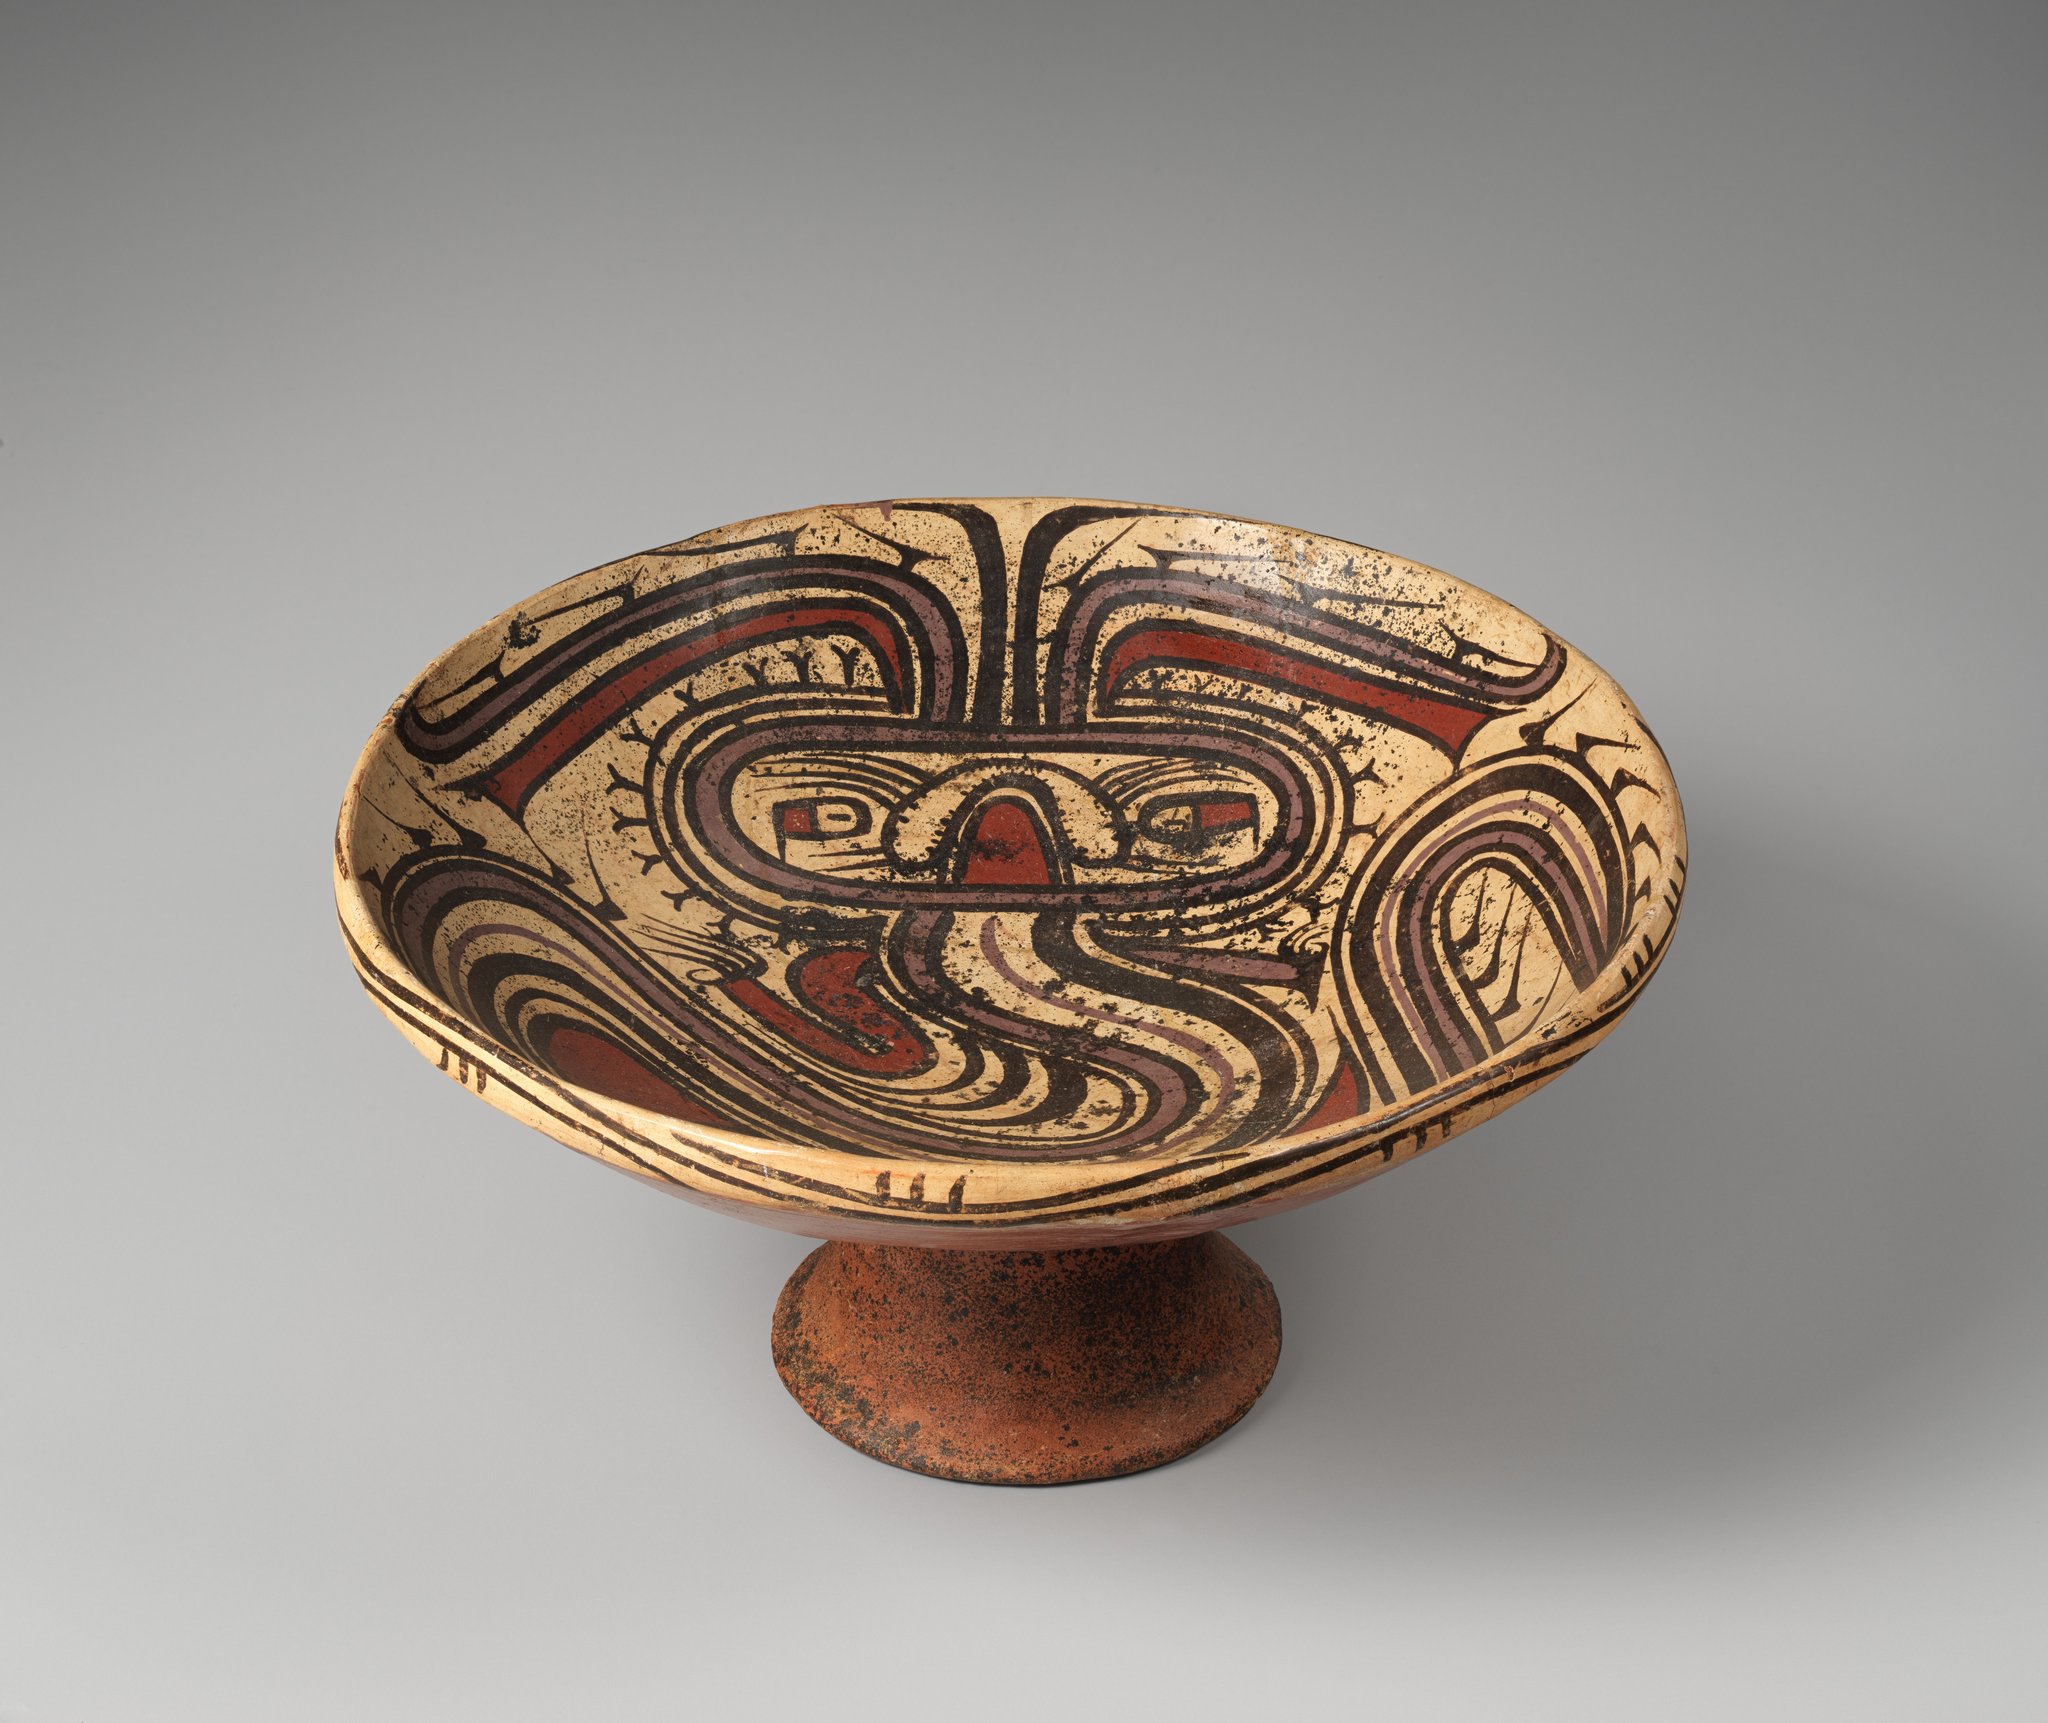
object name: plate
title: Pedestal plate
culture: conte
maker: coclé (conte) artist(s)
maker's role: artist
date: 750-950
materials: ceramic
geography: panama